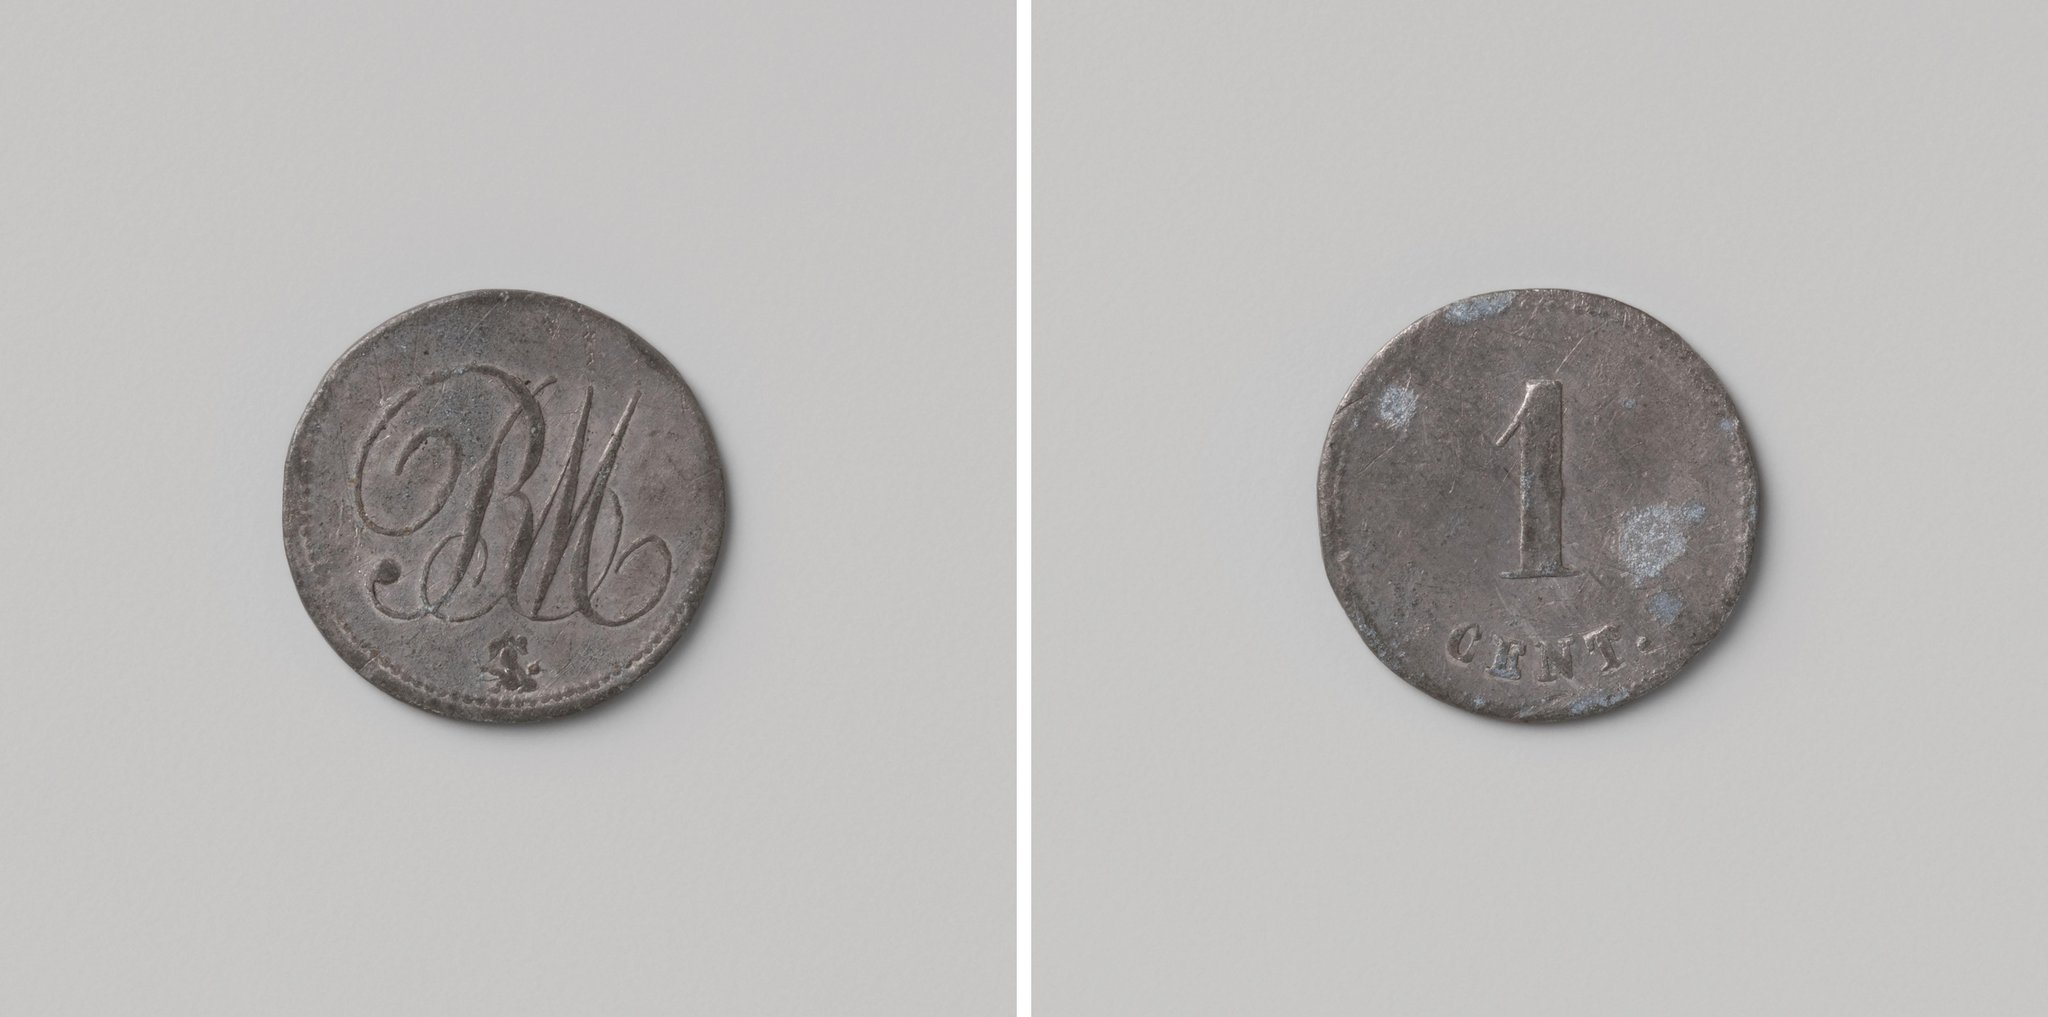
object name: monetary token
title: Huismunt van de kolonies Rijkevorsel en Merksplas ter waarde van 1 cent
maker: Anonymous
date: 1823-1839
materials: zinc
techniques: striking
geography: brussels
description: Zinken munt. Voorzijde: monogram van letters R en M boven merktekentje. Keerzijde: waardeaanduiding